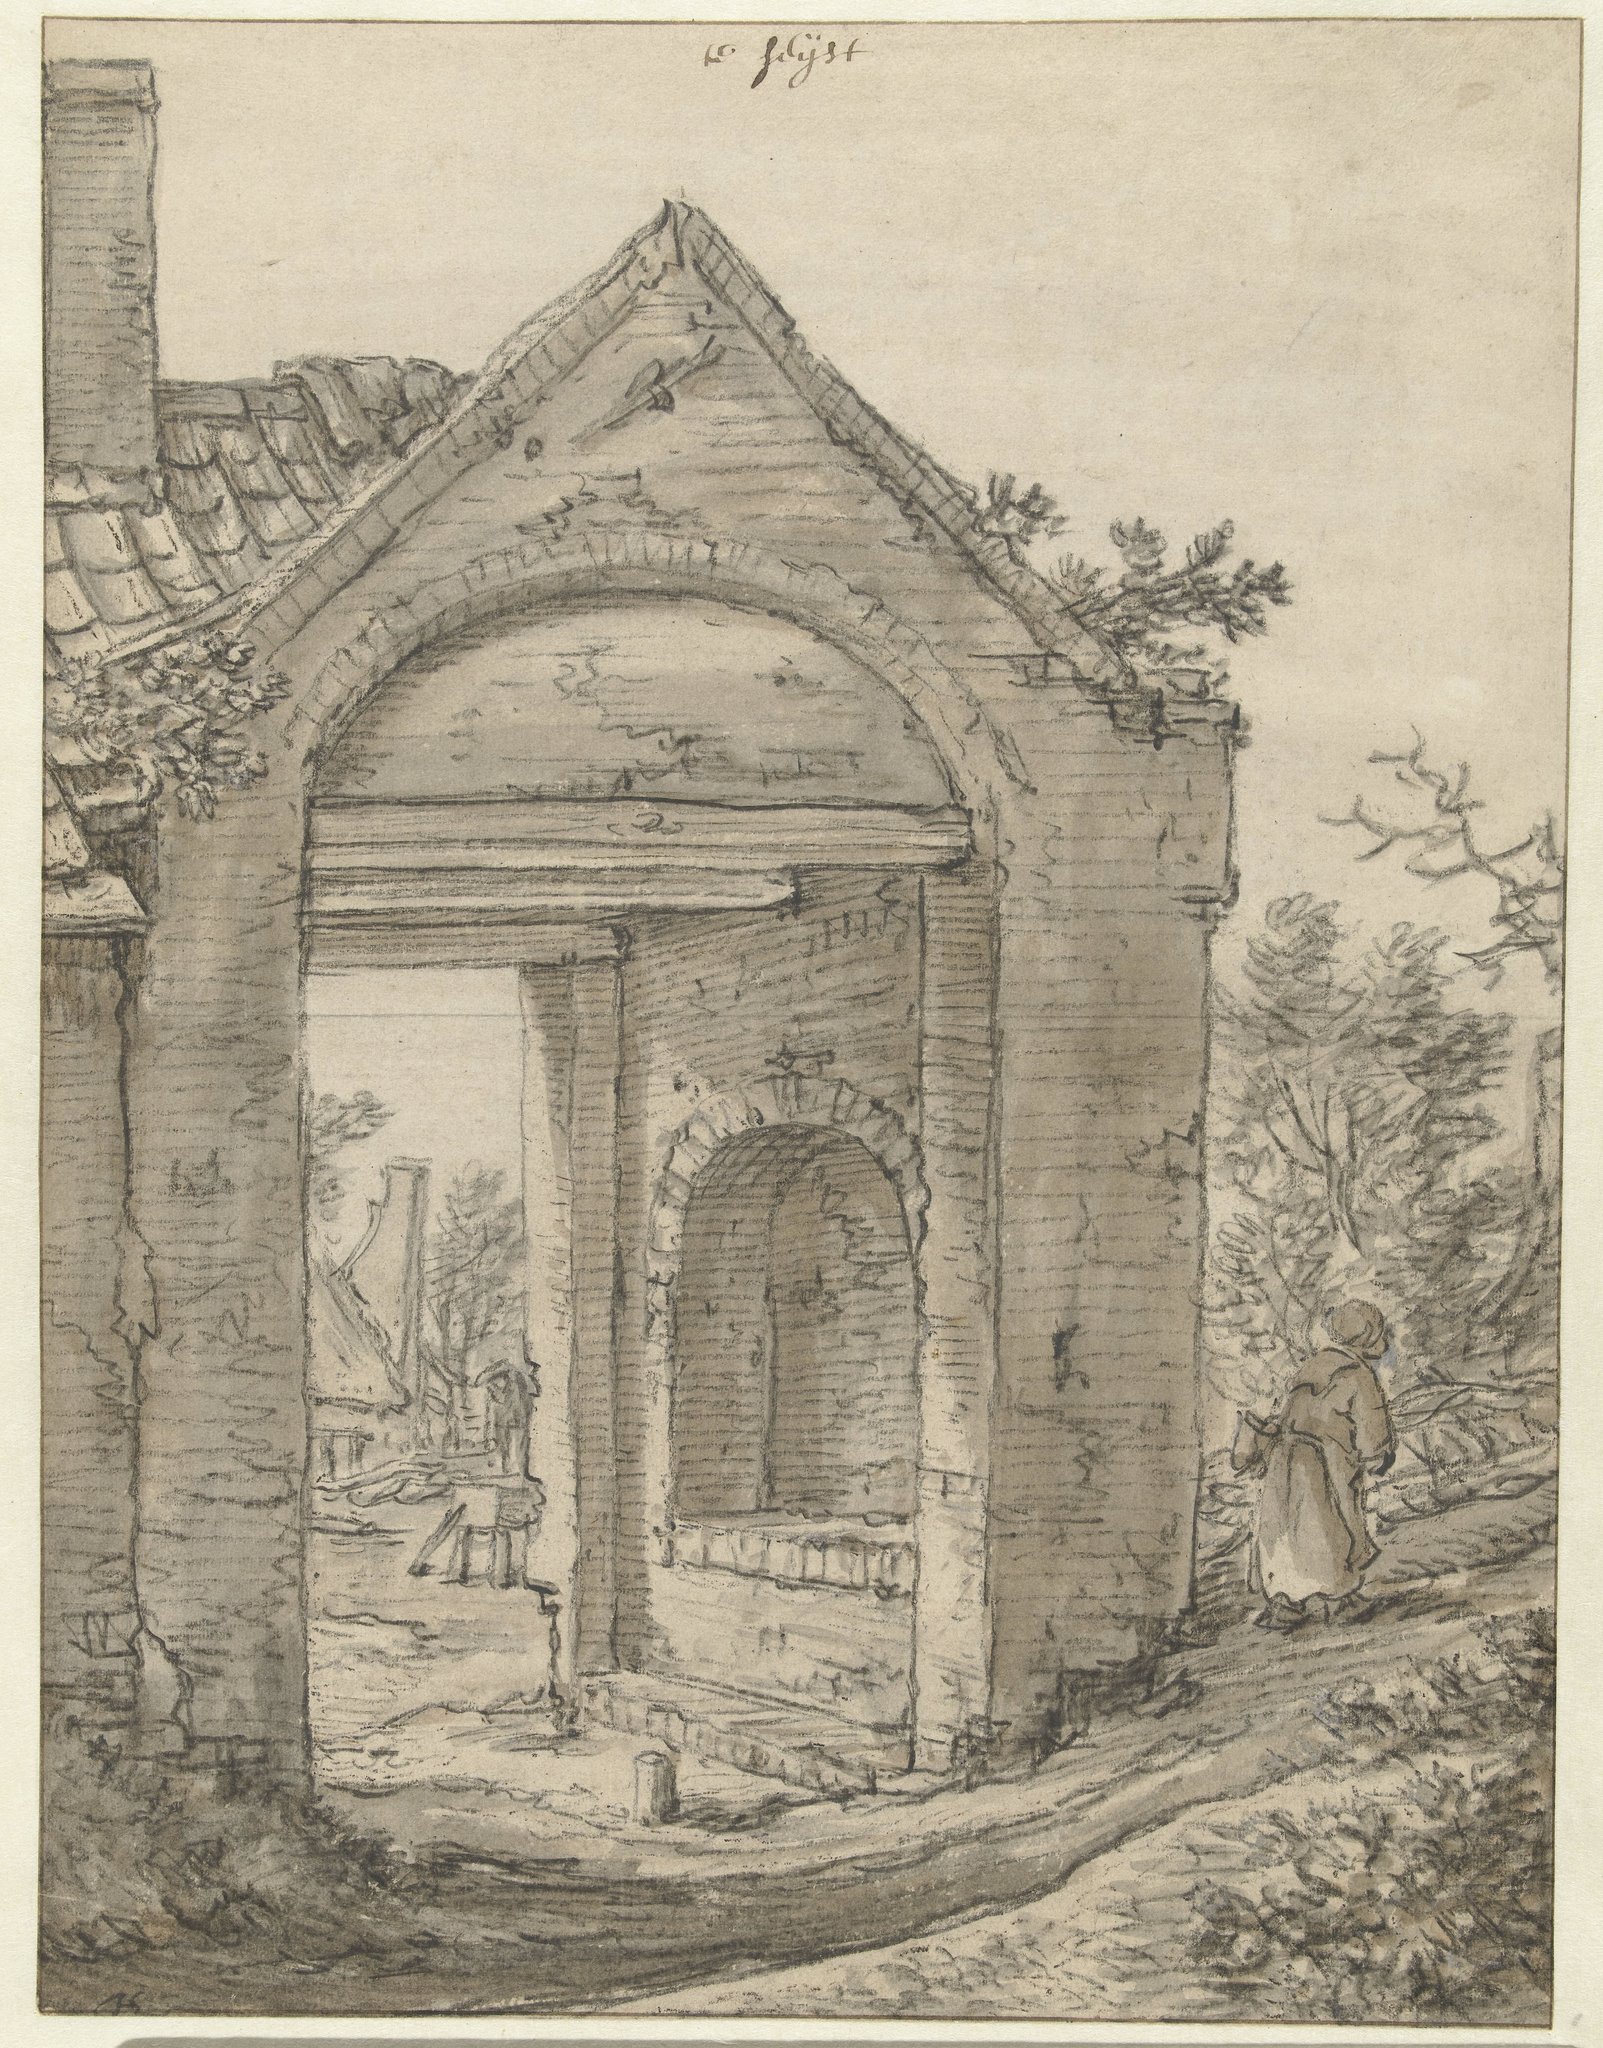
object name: drawing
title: Kerkhofpoort te Zeist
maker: herman saftleven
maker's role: draughtsman, painter, print maker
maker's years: 1609-1685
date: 1619-1685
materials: chalk, paint, paper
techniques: brush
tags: city-gate, zeist